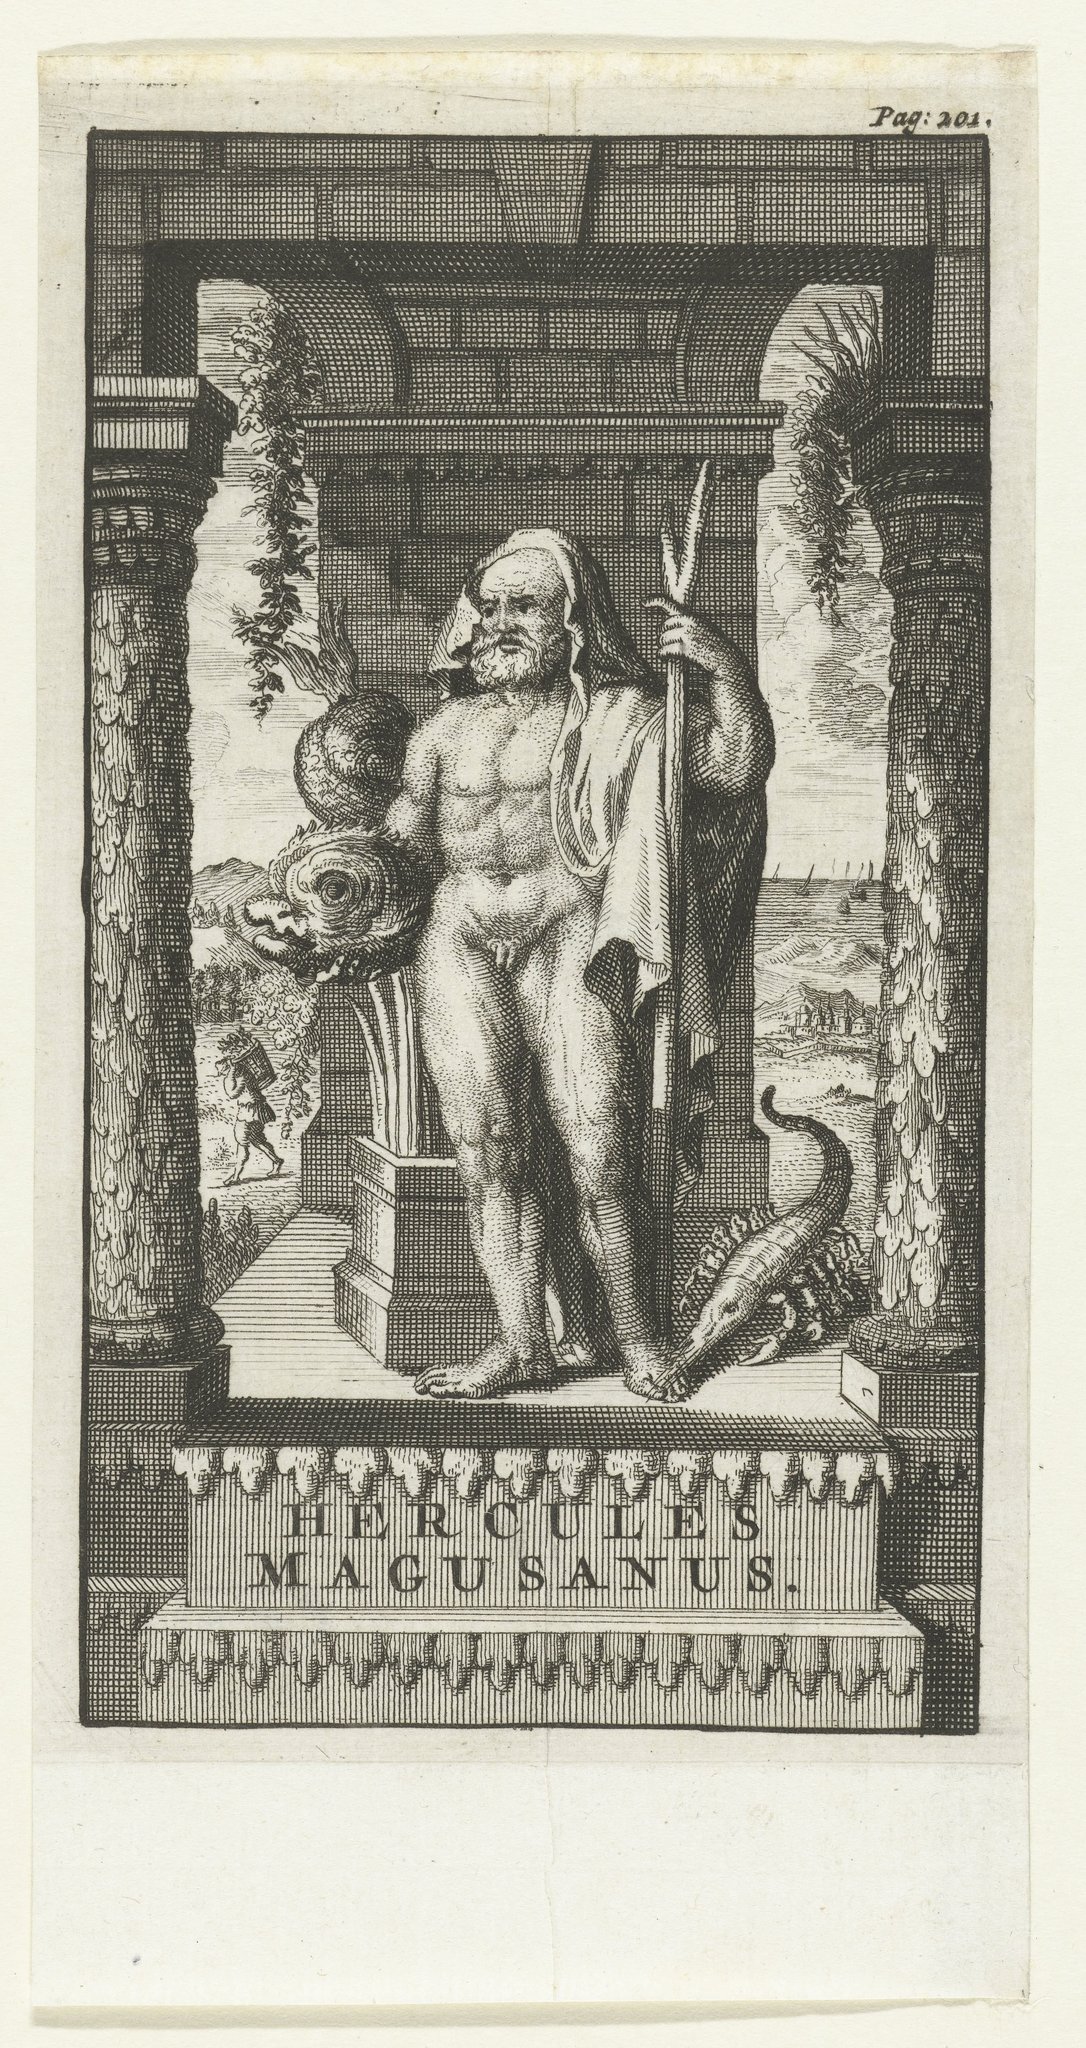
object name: print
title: Beeld van Hercules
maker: Anonymous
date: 1713-1717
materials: paper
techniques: etching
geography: netherlands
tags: (story of) hercules (heracles)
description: Illustratie voor: Mattheus Gargon, Walchersche arkadia, Samuel (I) Luchtmans, Leiden 1715-1717, pag. 201.